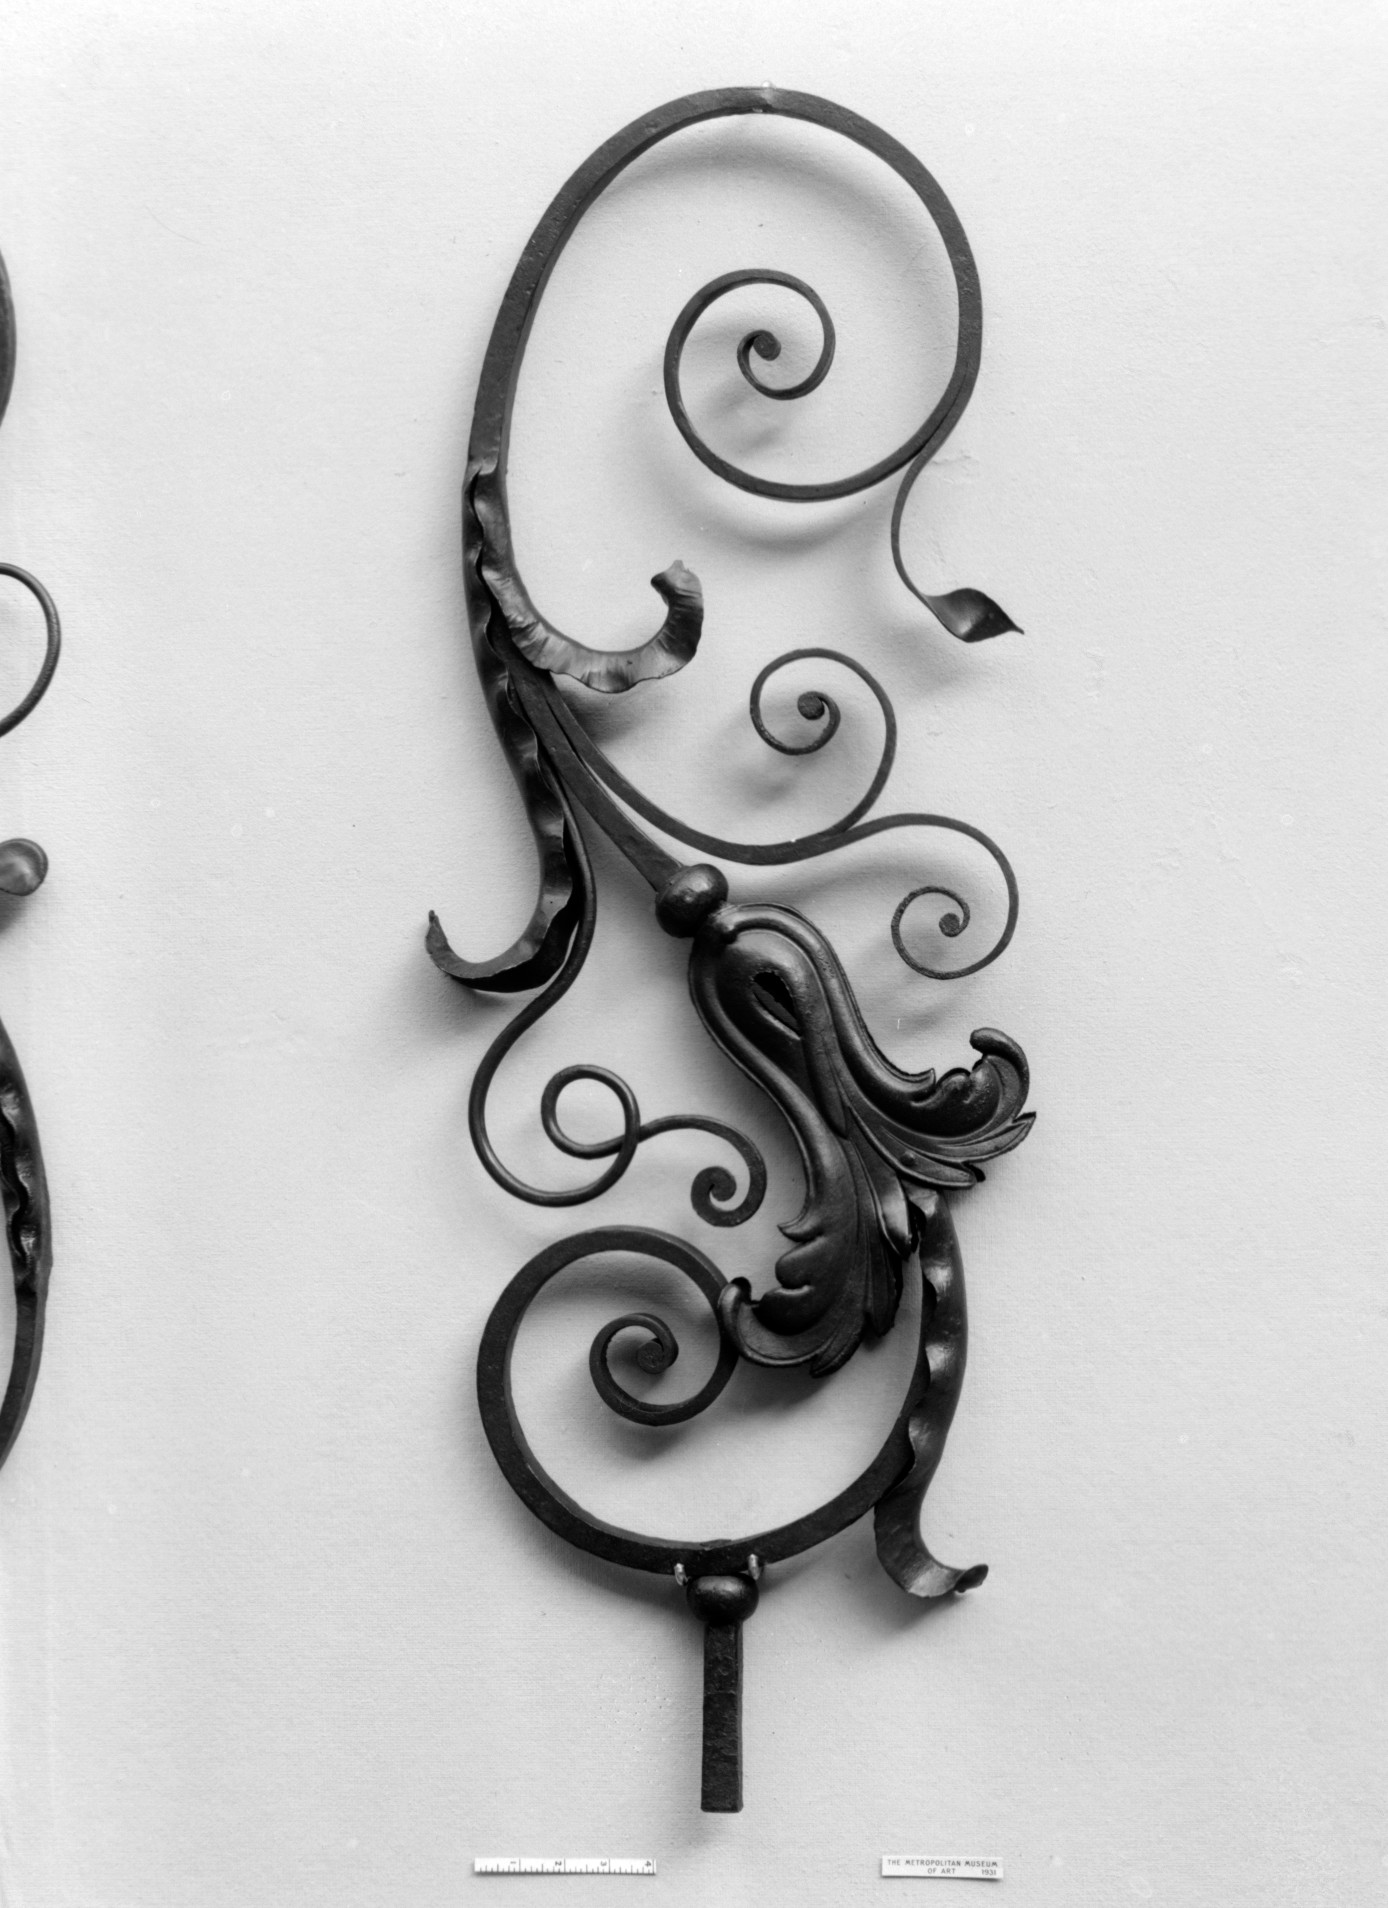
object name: baluster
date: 1730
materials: iron